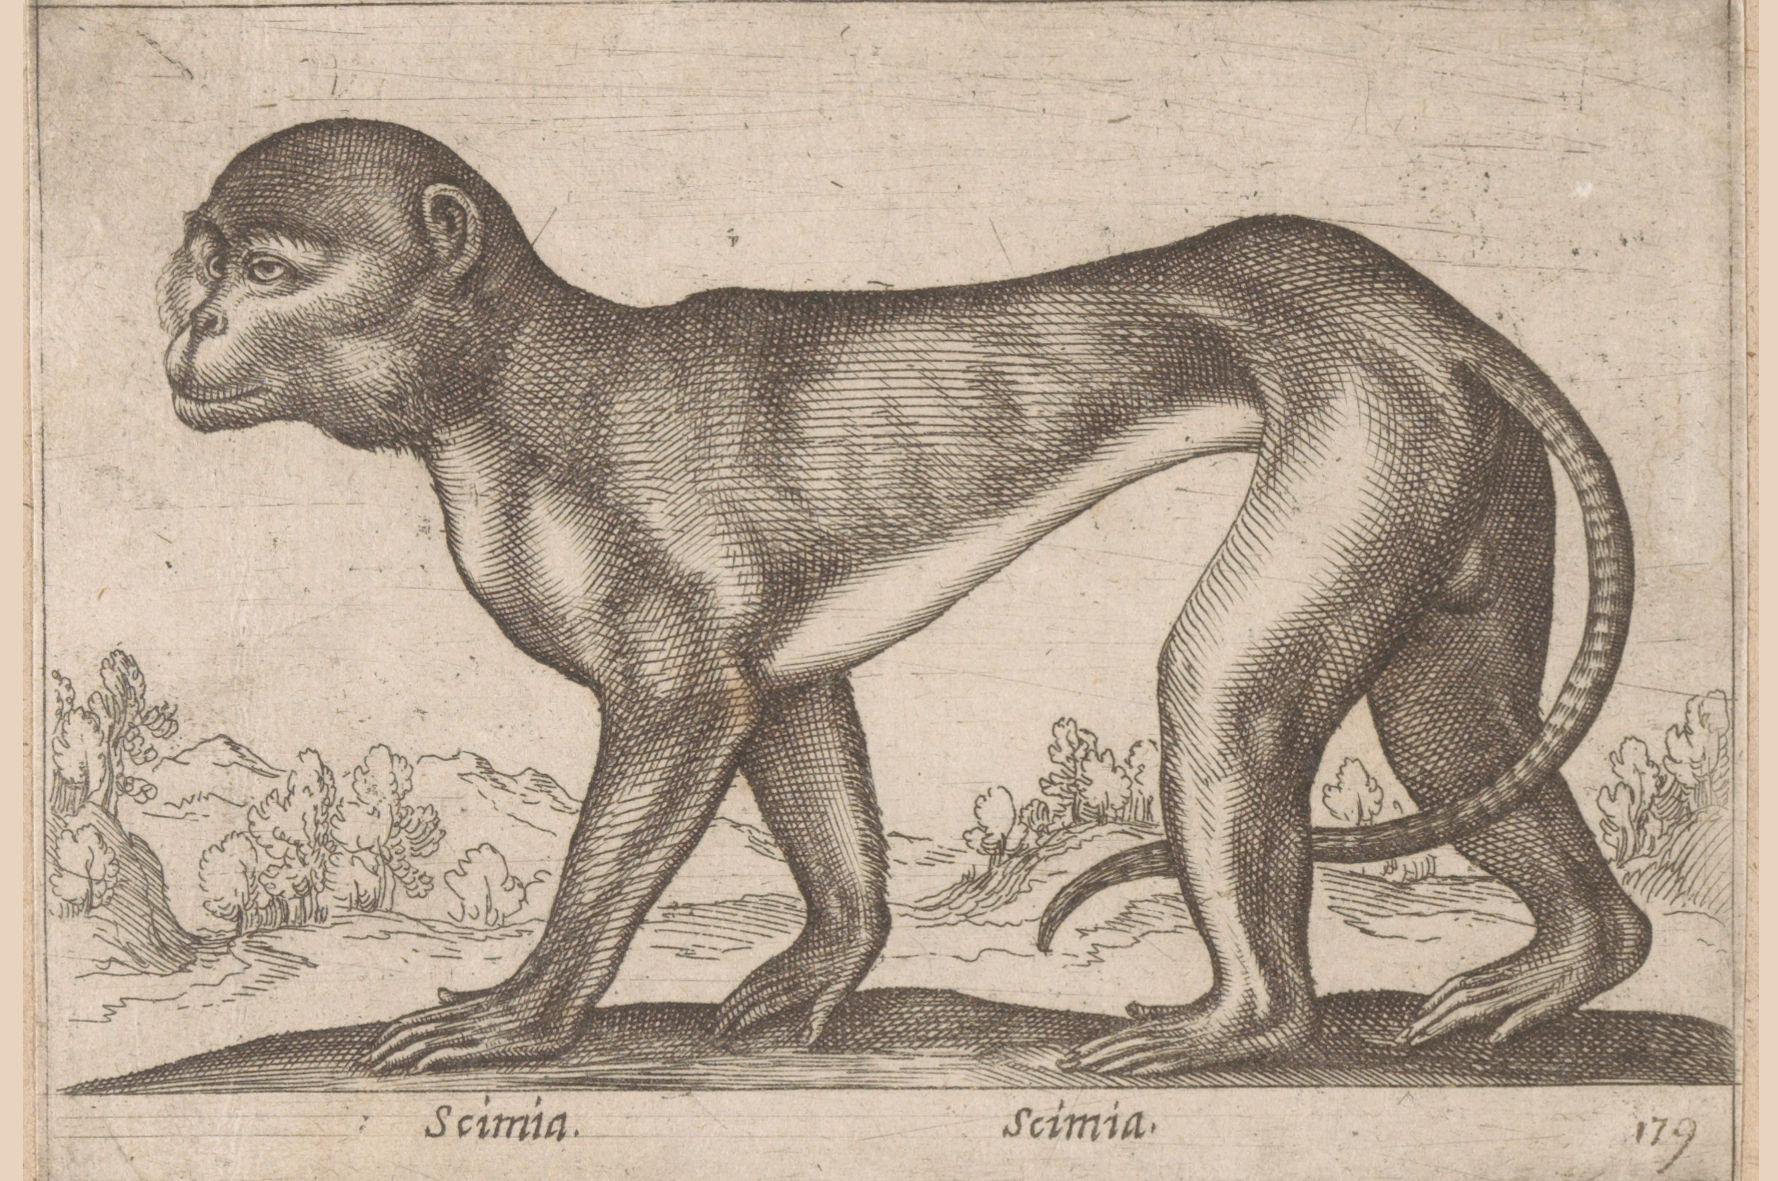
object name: print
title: Dieren en fabelwezens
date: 1565-1630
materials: paper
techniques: etching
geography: italy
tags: monkeys, apes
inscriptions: number: ‘179’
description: Deze prent maakt deel uit van een reeks prenten van dieren door Antonio Tempesta. Bekend is dat een tweede staat (met nummering) van deze serie is uitgegeven door Giovanni Giacomo de' Rossi in 1650. Onbekend is wie de eerste staat heeft uitgegeven en wanneer.